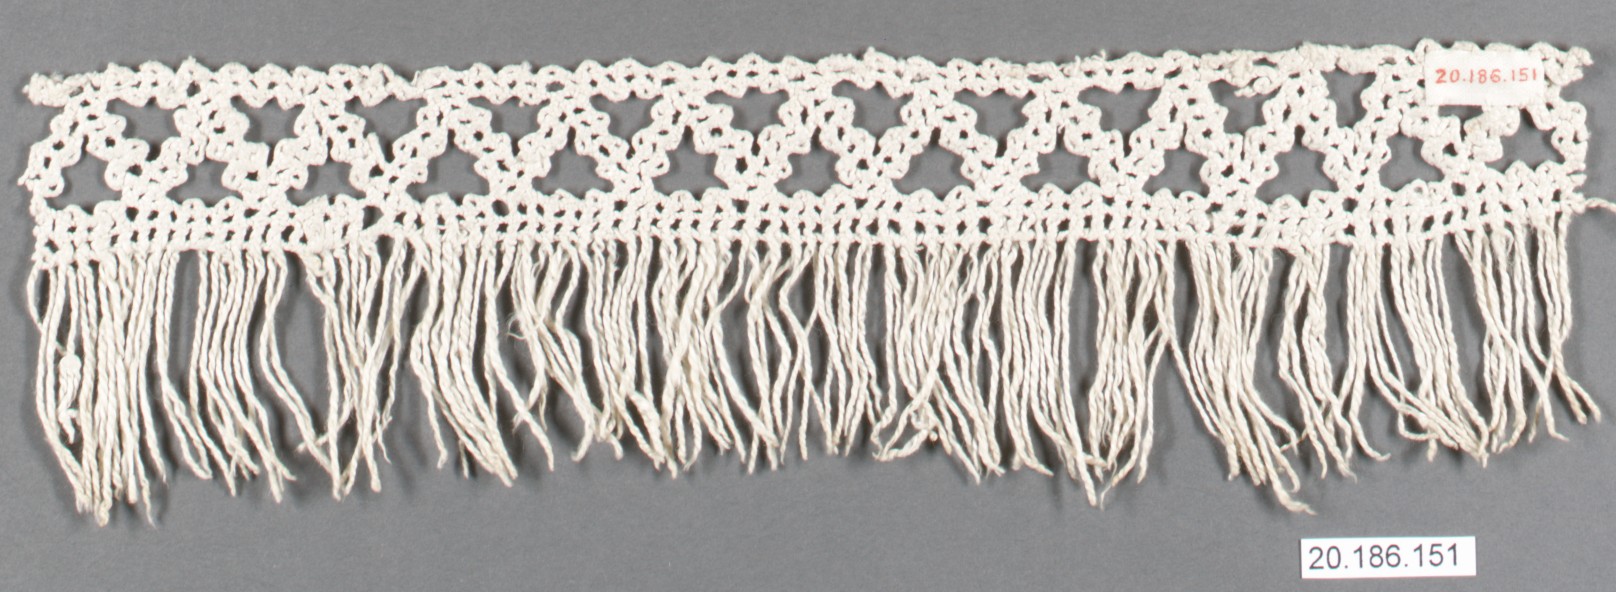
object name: edging with fringe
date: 1501-1600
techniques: lace